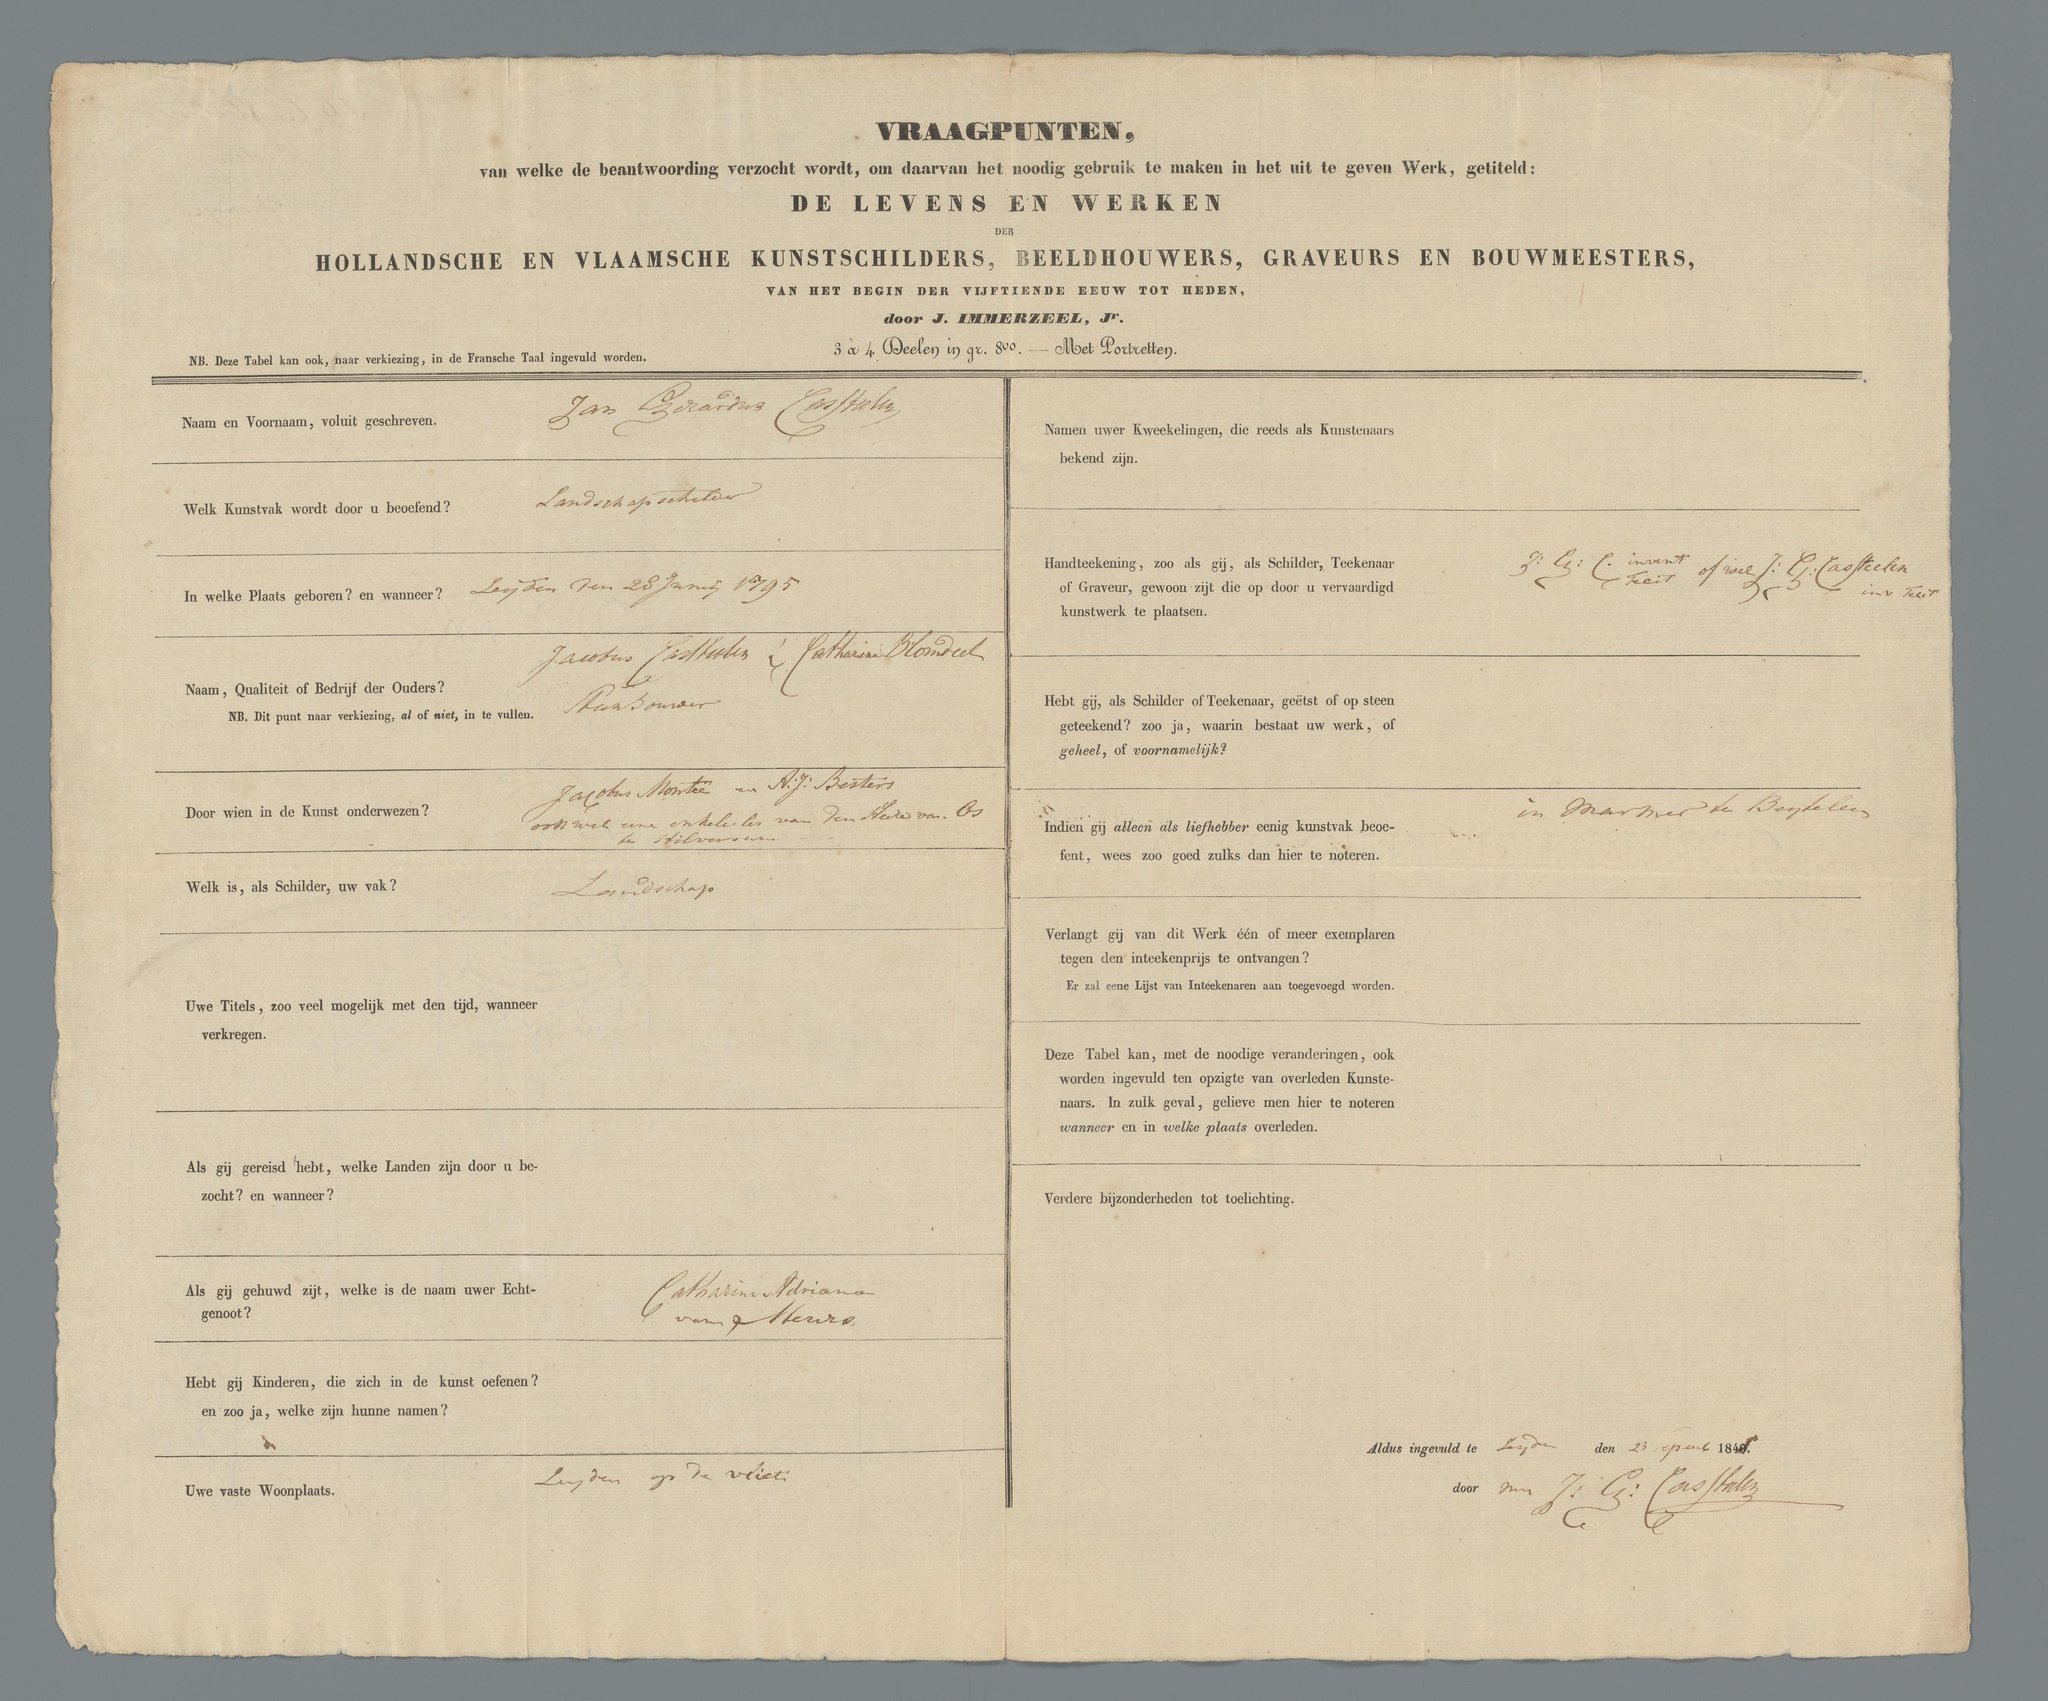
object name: questionnaire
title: Enquêteformulier ingevuld door Jan Gerardus Casteelen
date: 1841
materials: ink, paper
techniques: pen, printing, writing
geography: leiden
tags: leiden, jan gerardus cassteelen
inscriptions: inscription: ‘Vraagpunten,/ van welke de beantwoording verzocht wordt, om daarvan het noodig gebruik te maken in het uit te geven Werk, getiteld: De levens en werken/ der Hollandsche en Vlaamsche kunstschilders, beeldhouwers,/ graveurs en bouwmeesters, van het begin der vijftiende eeuw tot heden/ door J. Immerzeel, Jr.’, watermark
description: Niet geplaatst in: Immerzeel, J. Jr., De levens en werken der Hollandsche en Vlaamsche kunstschilders, beeldhouwers, graveurs en bouwmeesters, van het begin der vijftiende eeuw tot heden, Amsterdam: J.C. van Kesteren, 1842-1843.